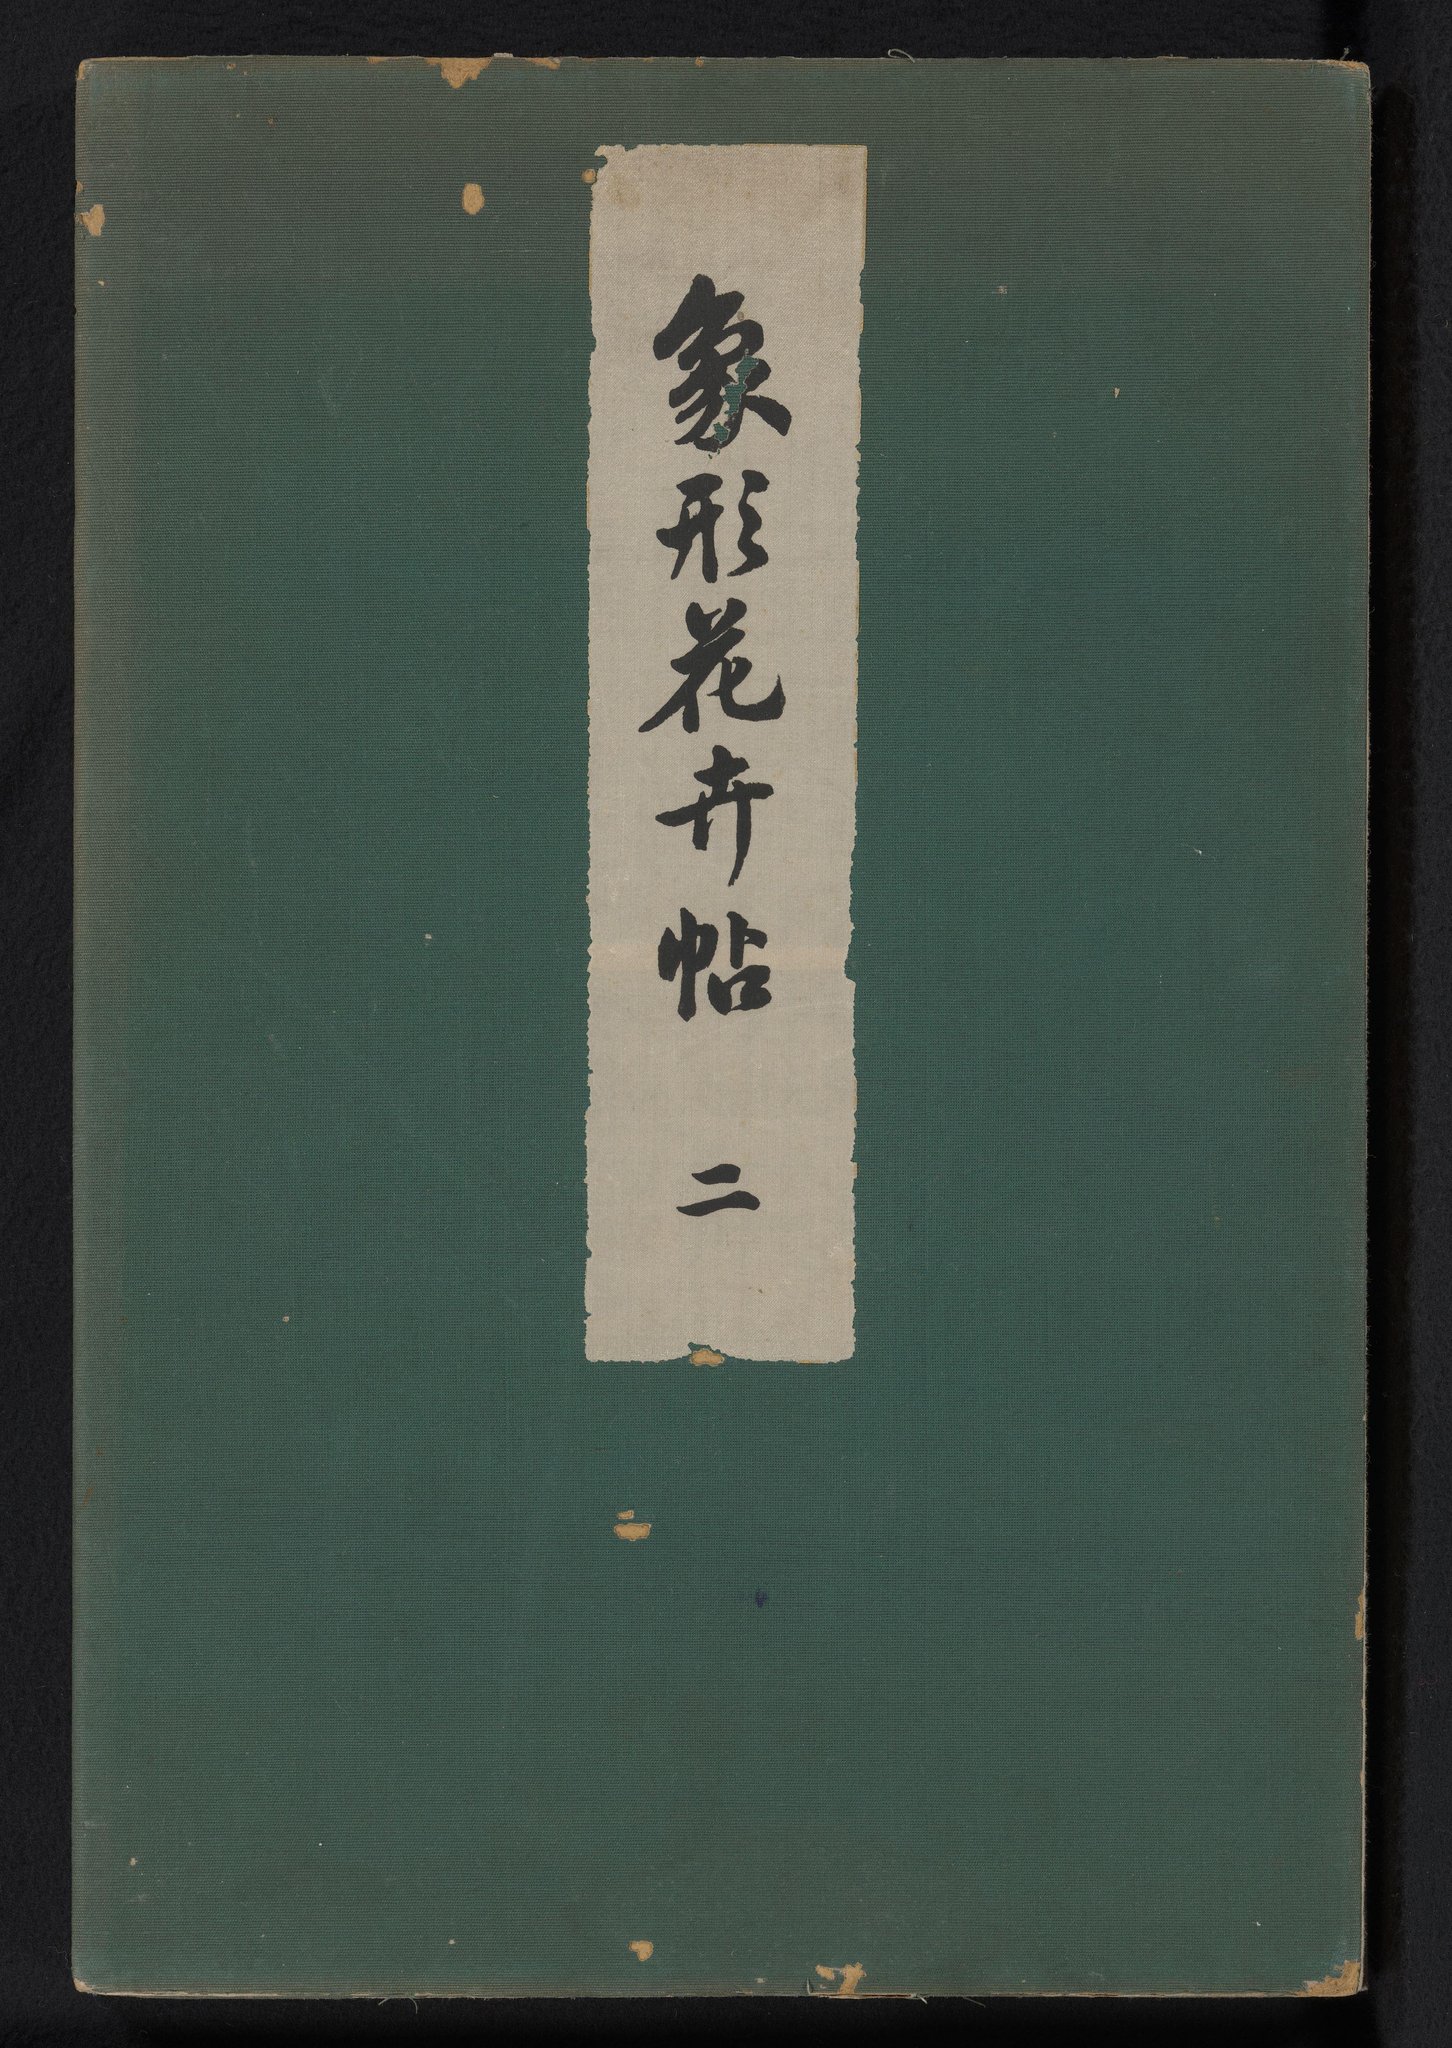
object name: prentrecueil, prentenalbum, prentalbum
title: Bloemen in groot formaat - deel twee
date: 1926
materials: paper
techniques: woodcut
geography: japan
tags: flowers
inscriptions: date